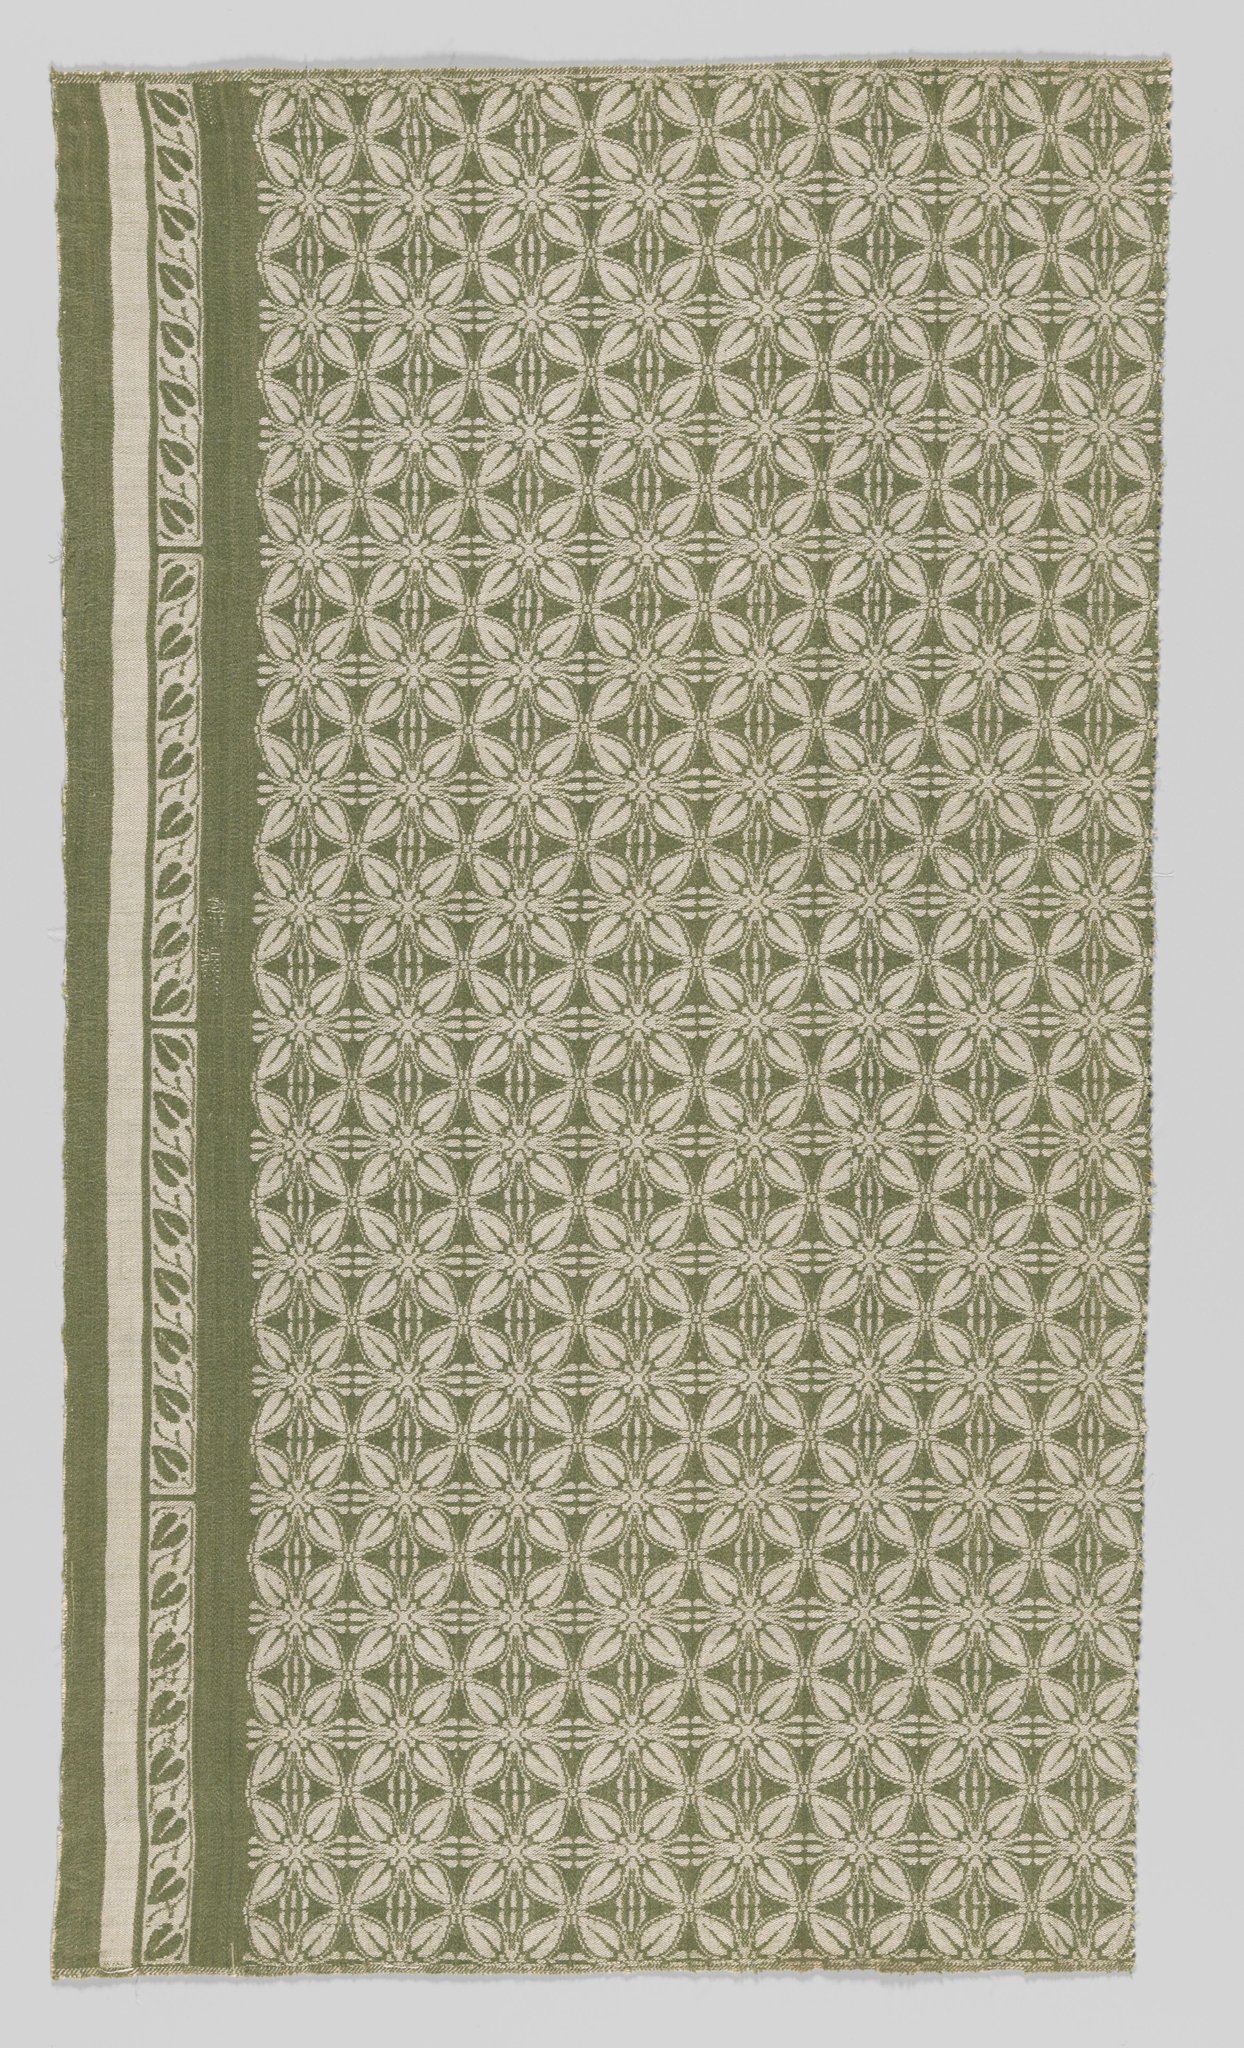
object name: upholstery fabric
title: Staal bespanningsstof van linnendamast met motief "Lotos"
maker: chris lebeau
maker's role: draughtsman, print maker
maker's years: 1878-1945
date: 1911-1915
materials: linen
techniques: damask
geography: eindhoven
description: Staal bespanningsstof van linnendamast met gestileerd bloempatroon in naturel op een olijfgroene grond.